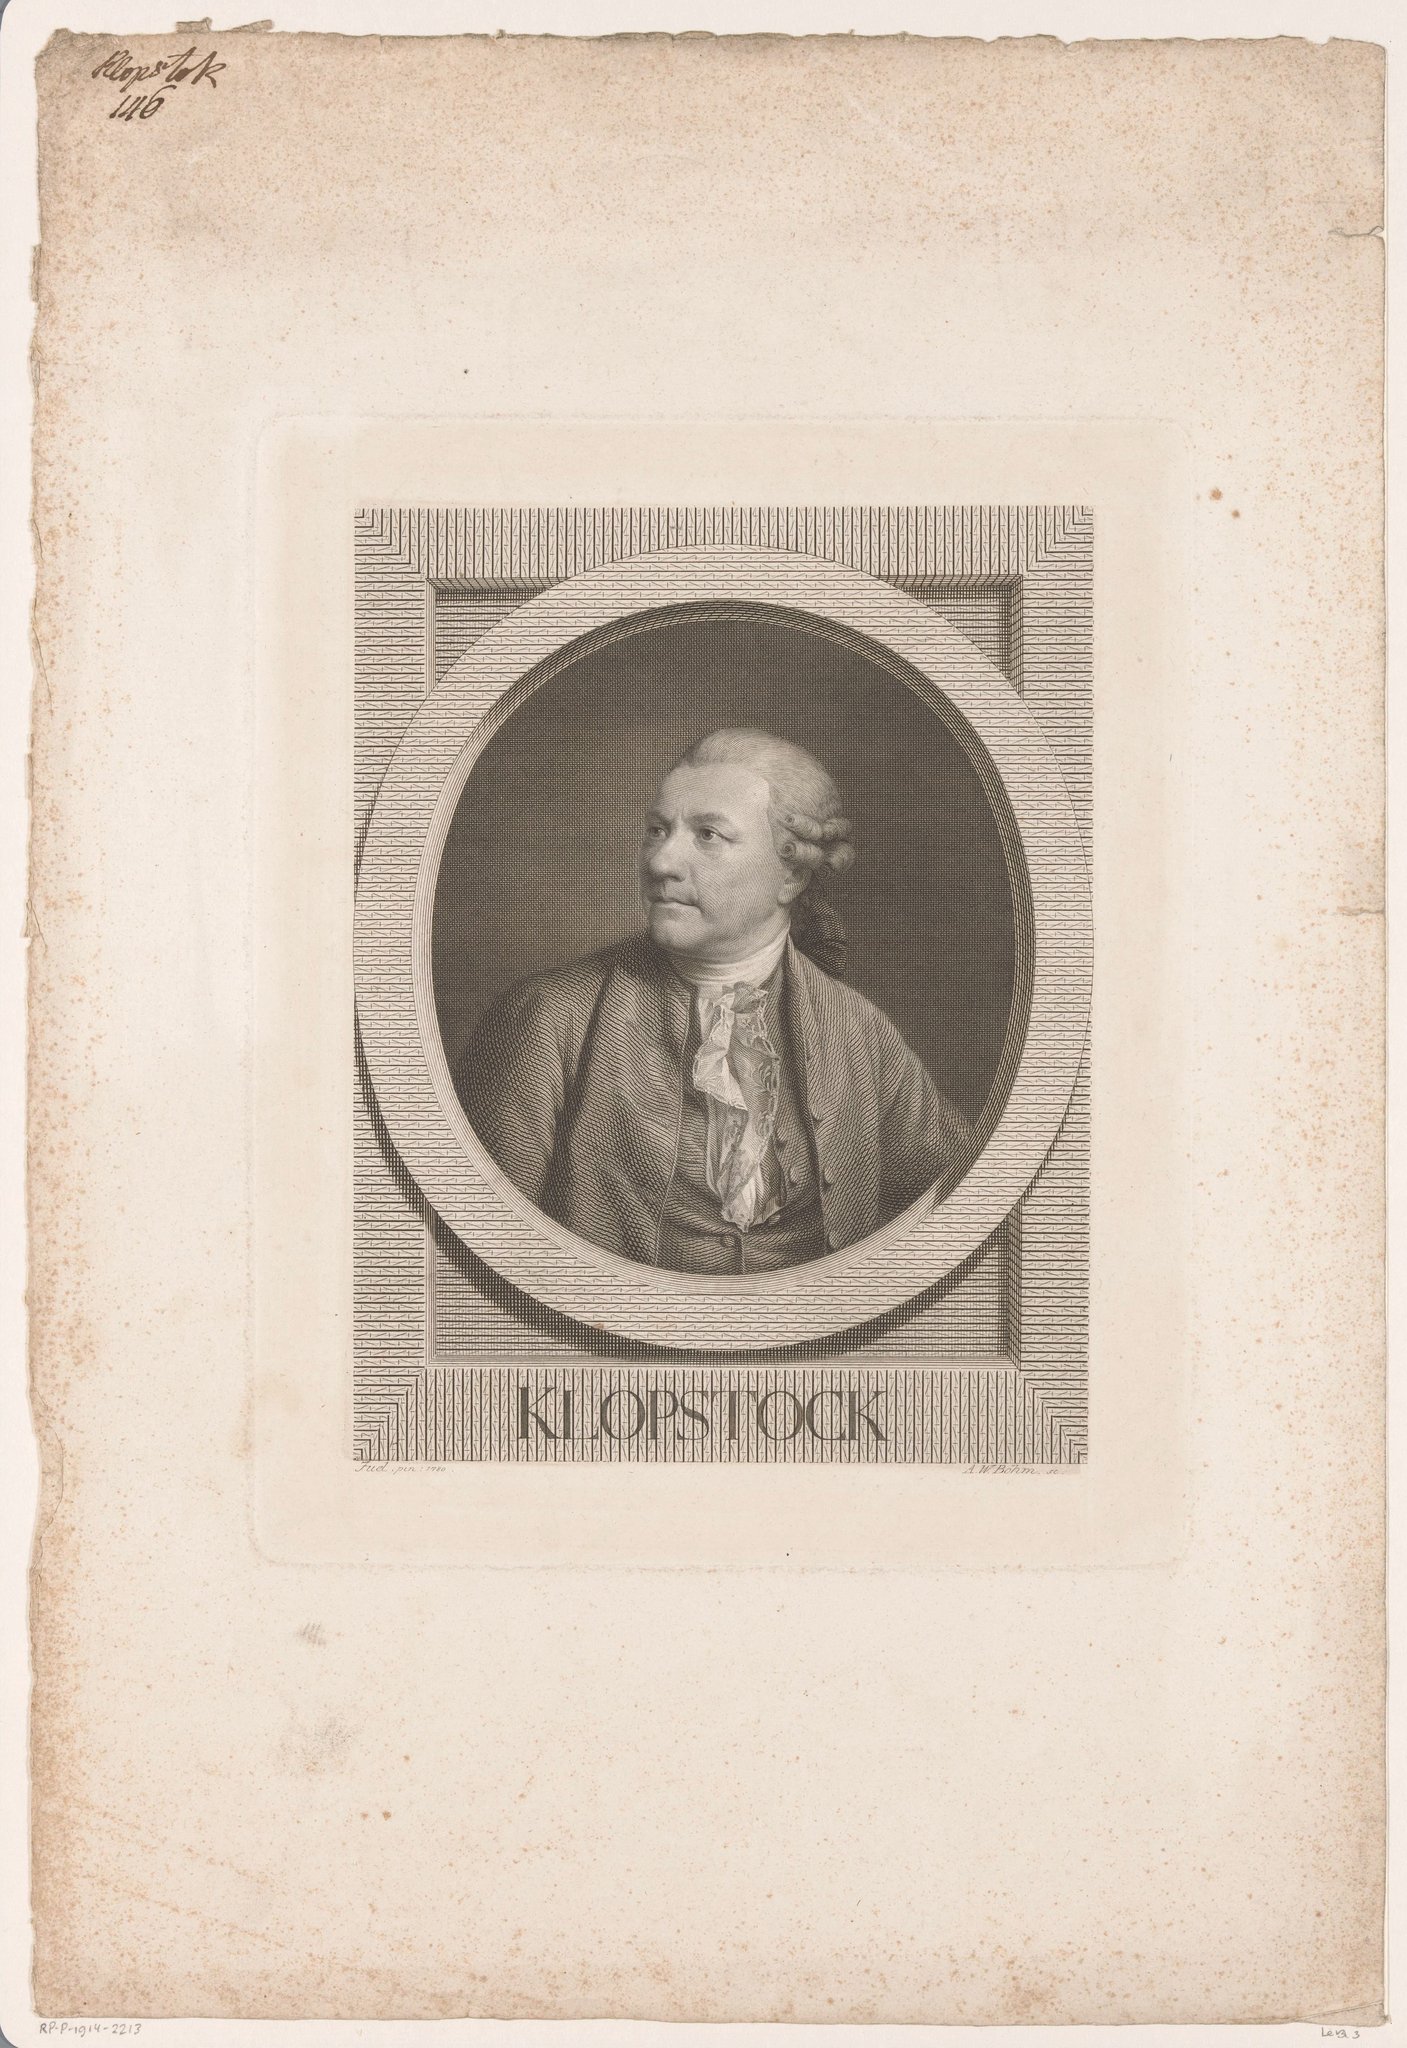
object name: print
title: Portret van Friedrich Gottlieb Klopstock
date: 1797-1823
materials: paper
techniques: engraving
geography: leipzig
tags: historical persons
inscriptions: collector's mark: Lugt 2228